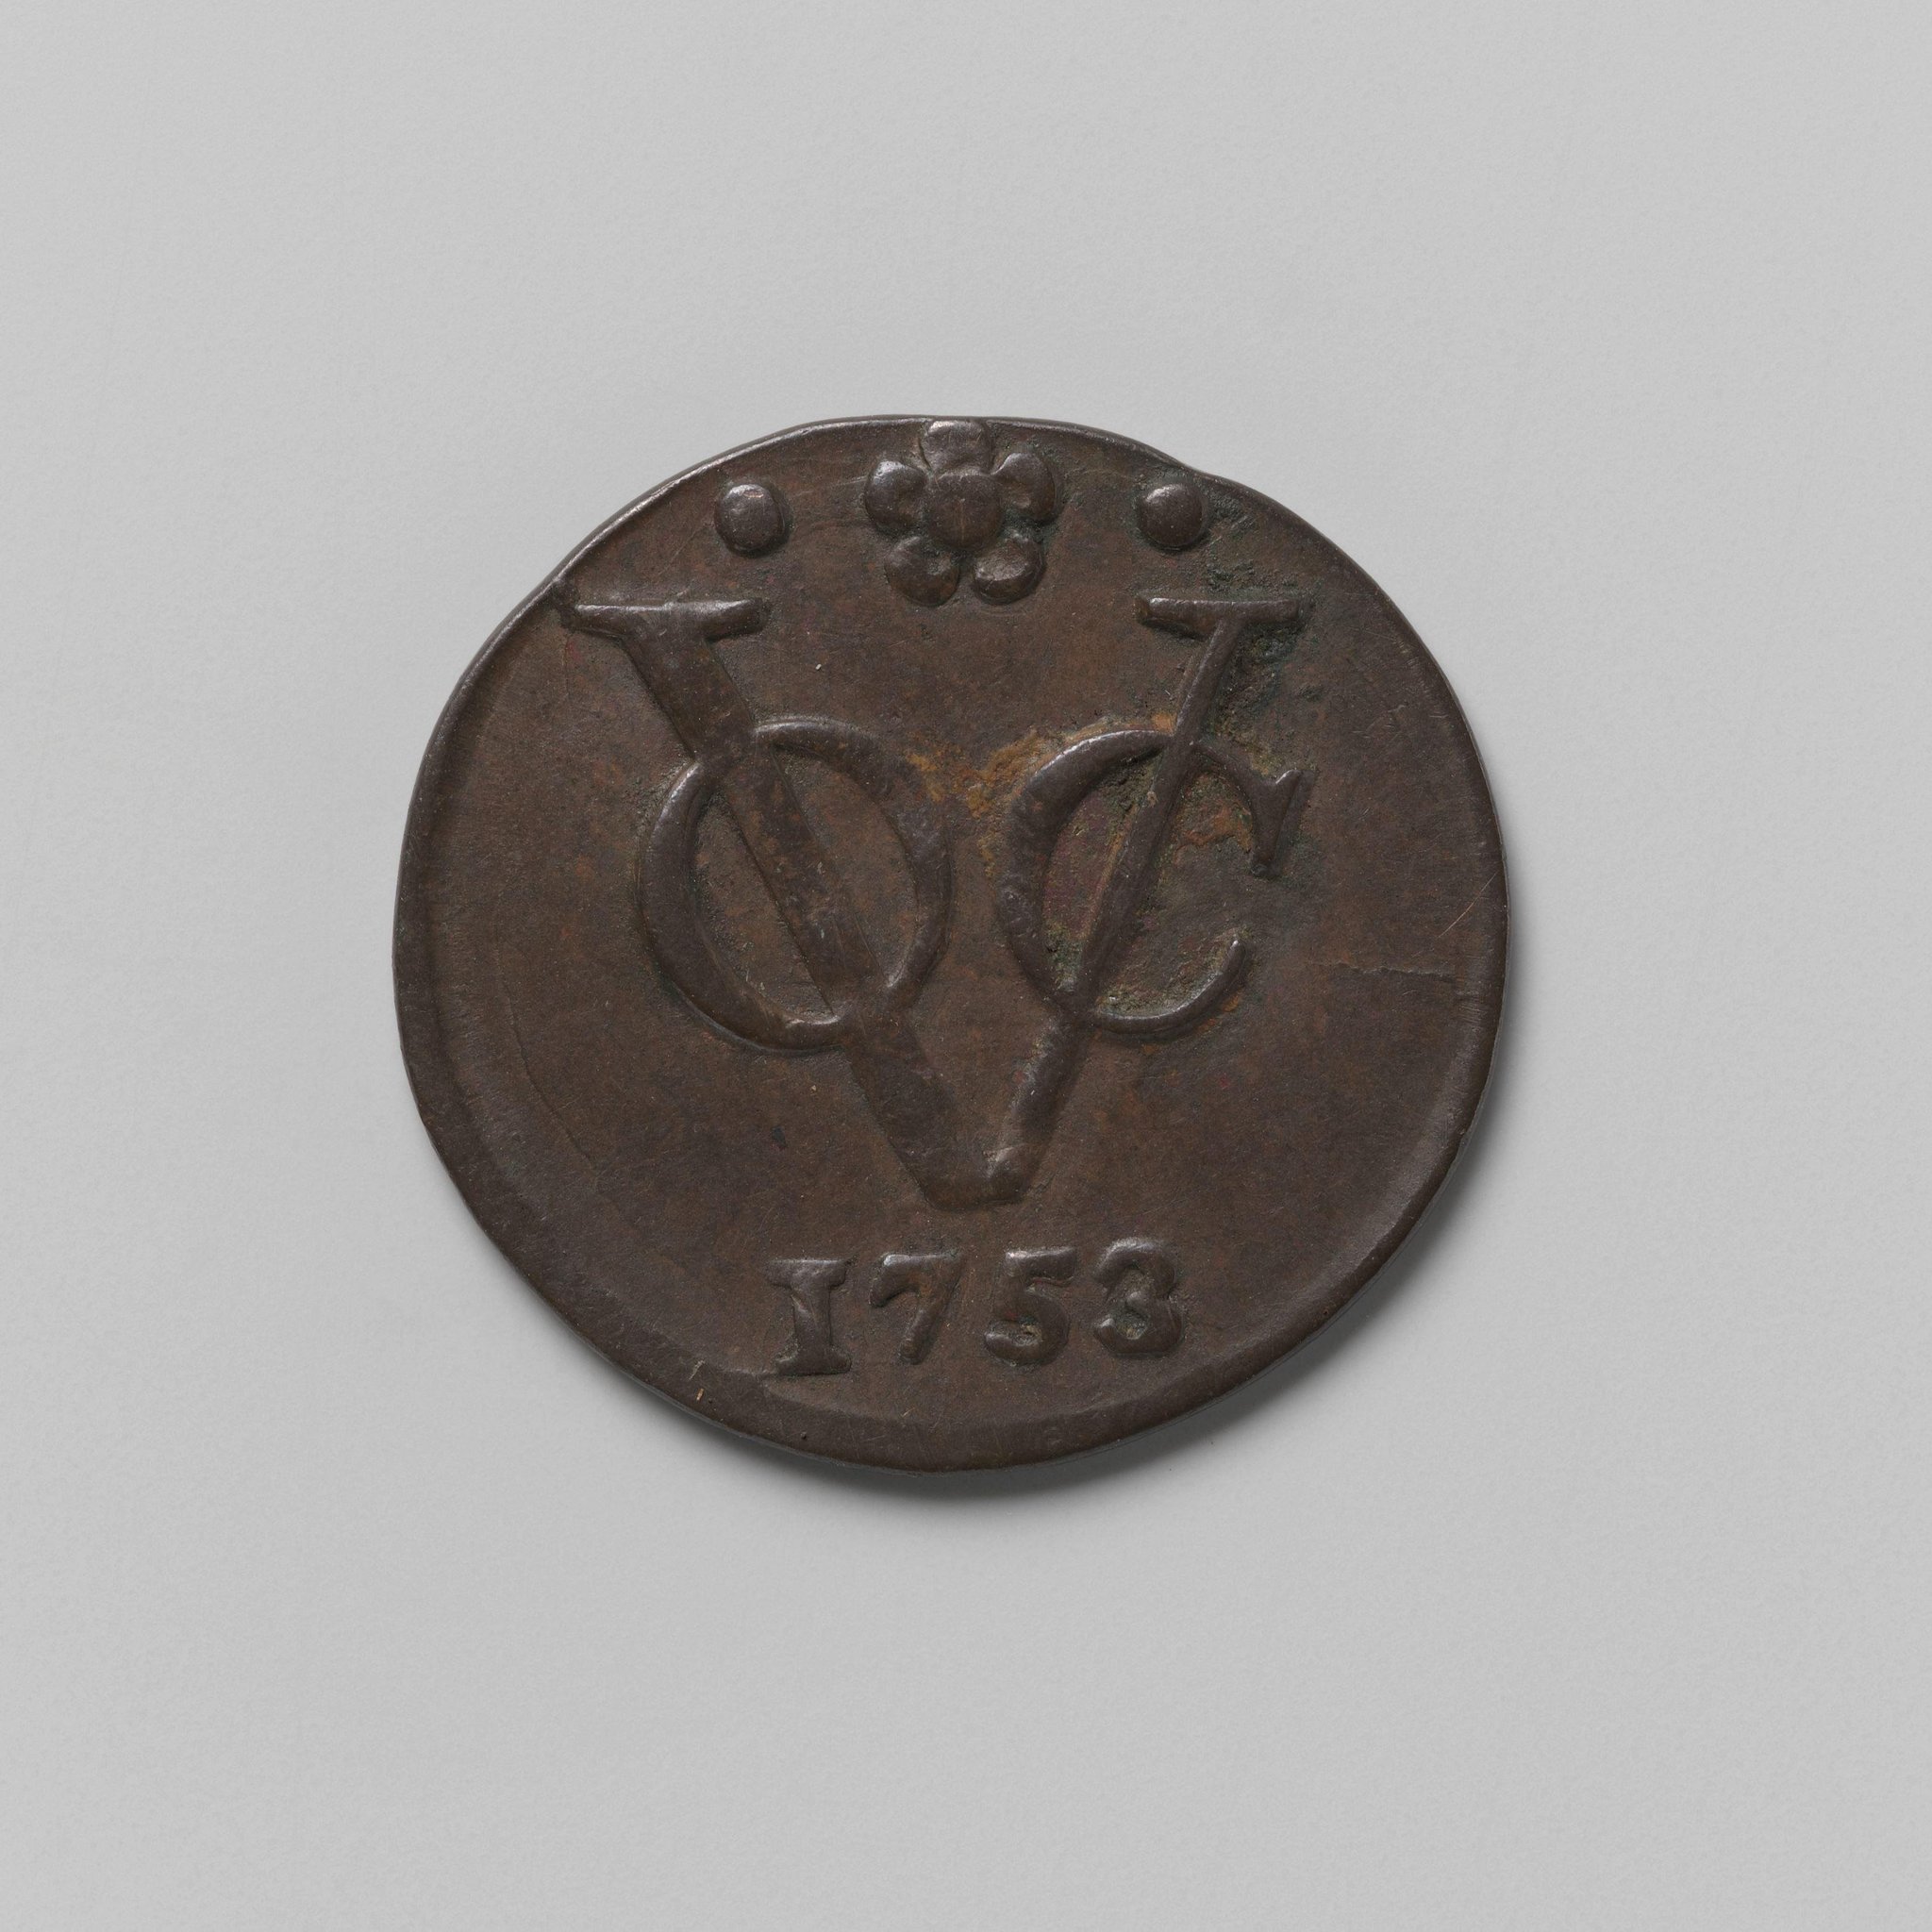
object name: coin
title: VOC, ½ duit Holland, 1753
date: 1753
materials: copper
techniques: striking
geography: dordrecht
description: Koperen munt. Voorzijde: gekroond wapenschild van Holland. Keerzijde: monogram van de VOC, waarboven muntteken en waaronder jaartal. Gladde rand.